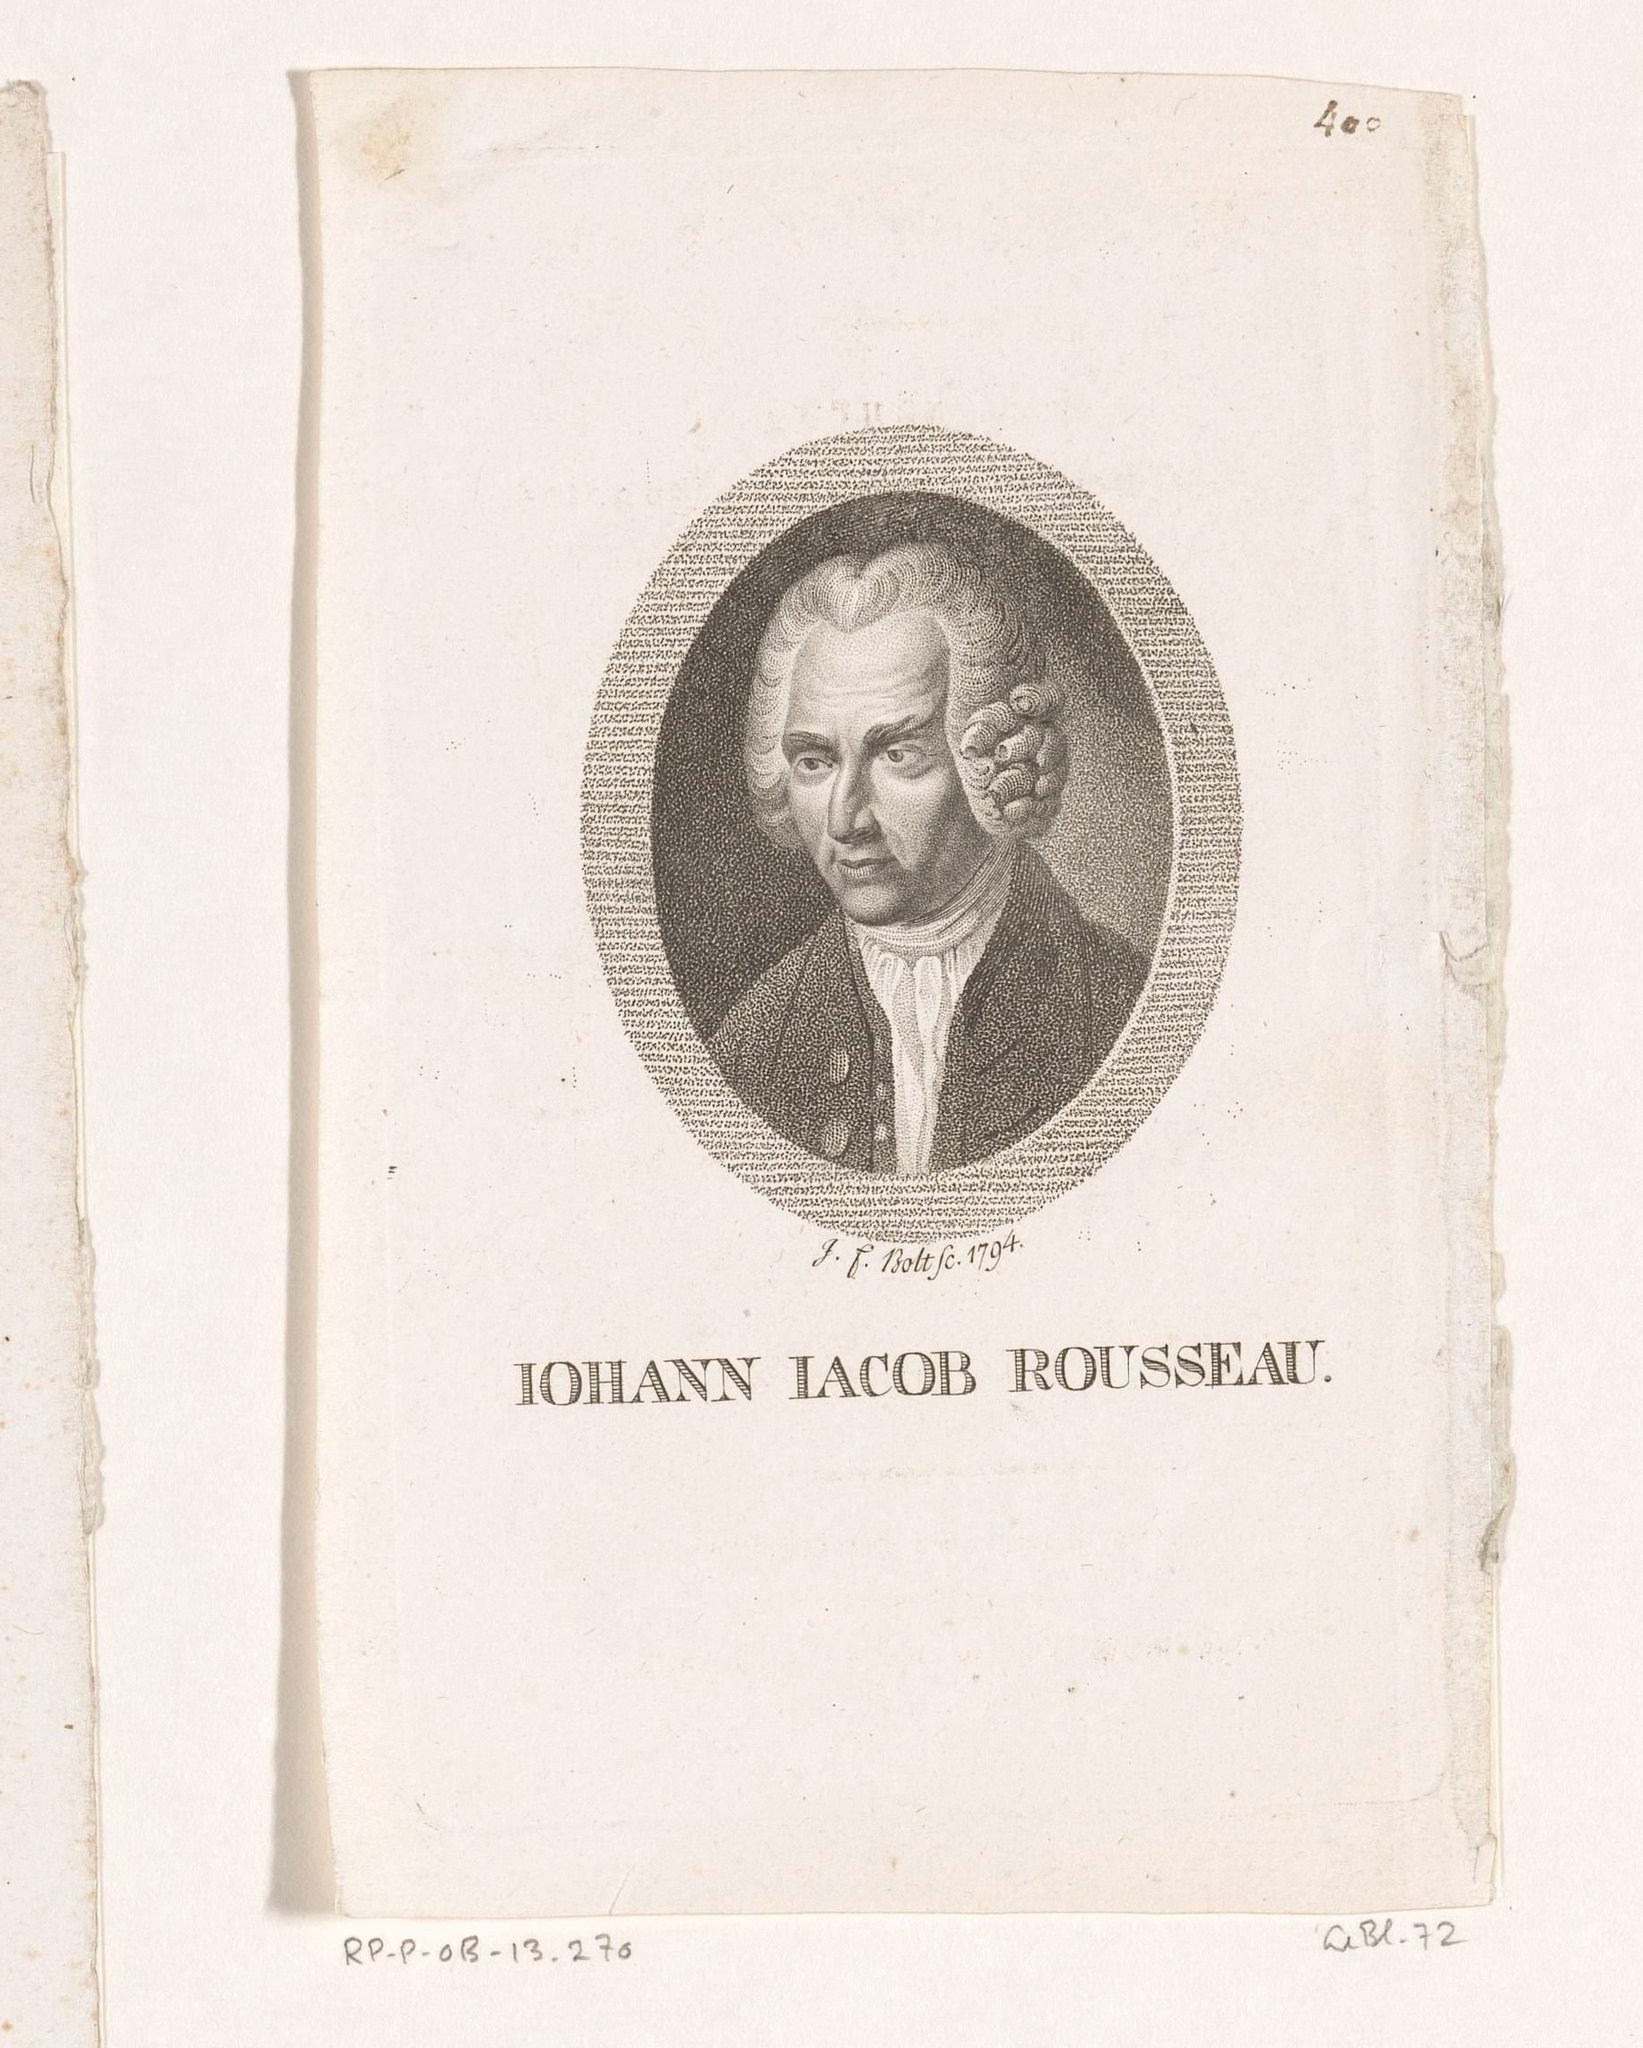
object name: print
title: Portret van Jean-Jacques Rousseau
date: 1794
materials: paper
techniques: stippling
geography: hamburg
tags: historical persons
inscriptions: date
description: Prent afkomstig uit: Minerva. Ein Journal historischen und politischen Inhalt [uitgegeven door:] Johann Wilhelm Archenholz. Erster Band für das Jahr 1794. Januar, Februar, März. Hamburg: Johann Wilhelm Archenholz en Benjamin Gottlob Hoffmann, [1794].